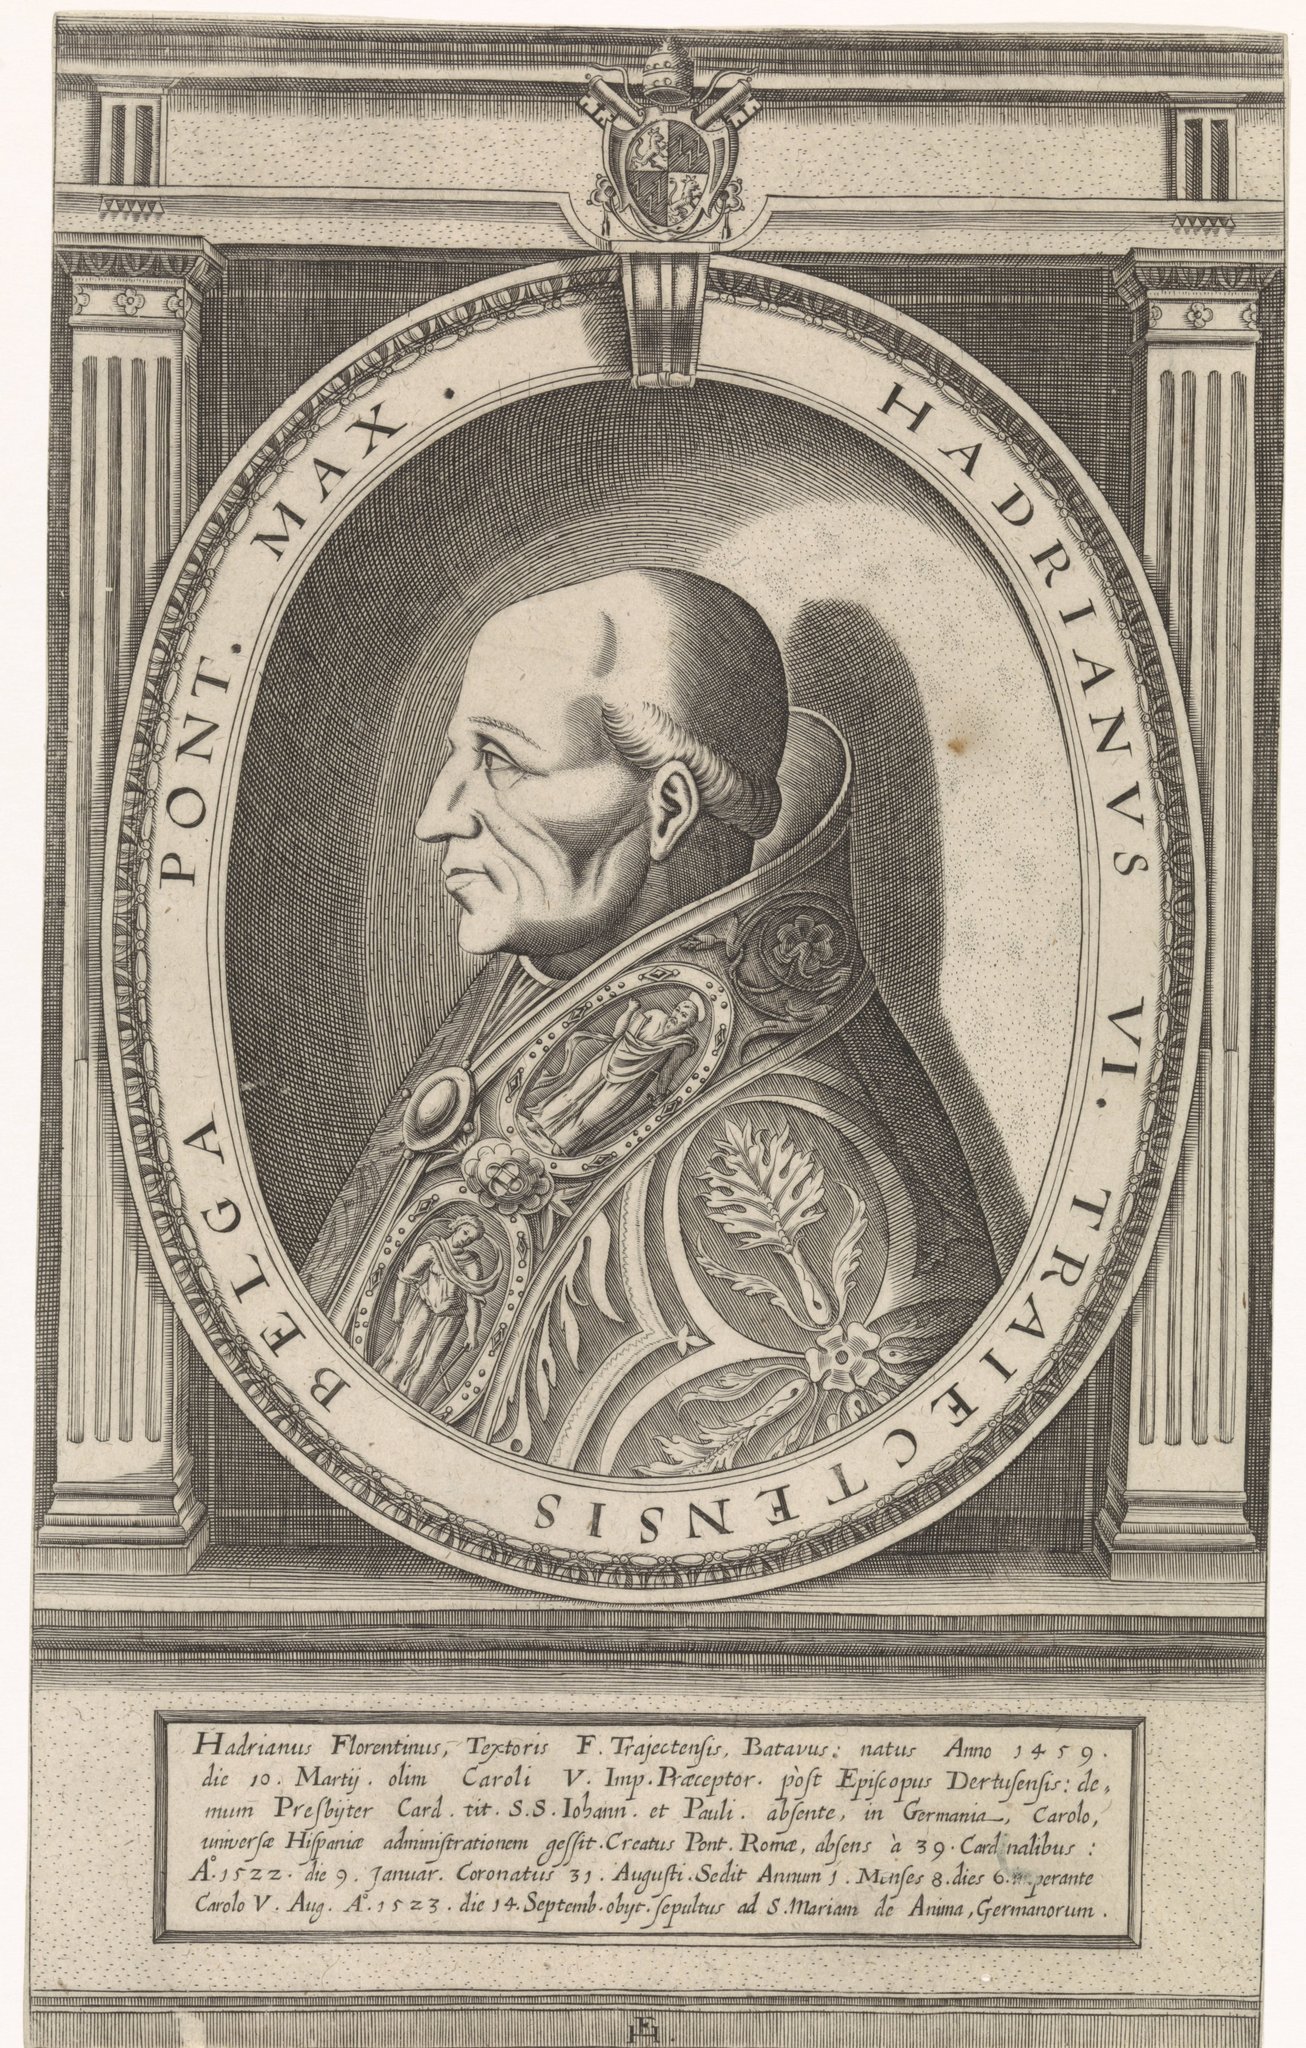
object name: print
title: Portret van paus Adrianus VI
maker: friedrich van hulsen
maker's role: print maker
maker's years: 1580-1660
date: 1590-1665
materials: paper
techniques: engraving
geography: germany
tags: utrecht, rome, clergyman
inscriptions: collector's mark: Lugt 2228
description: Portret van paus Adrianus VI gehuld in het pauselijk gewaad. Buste en profil naar links in een ovale lijst met randschrift. Midden boven is zijn pauselijk wapen afgebeeld. Onder het portret zes tekstregels in het Latijn.